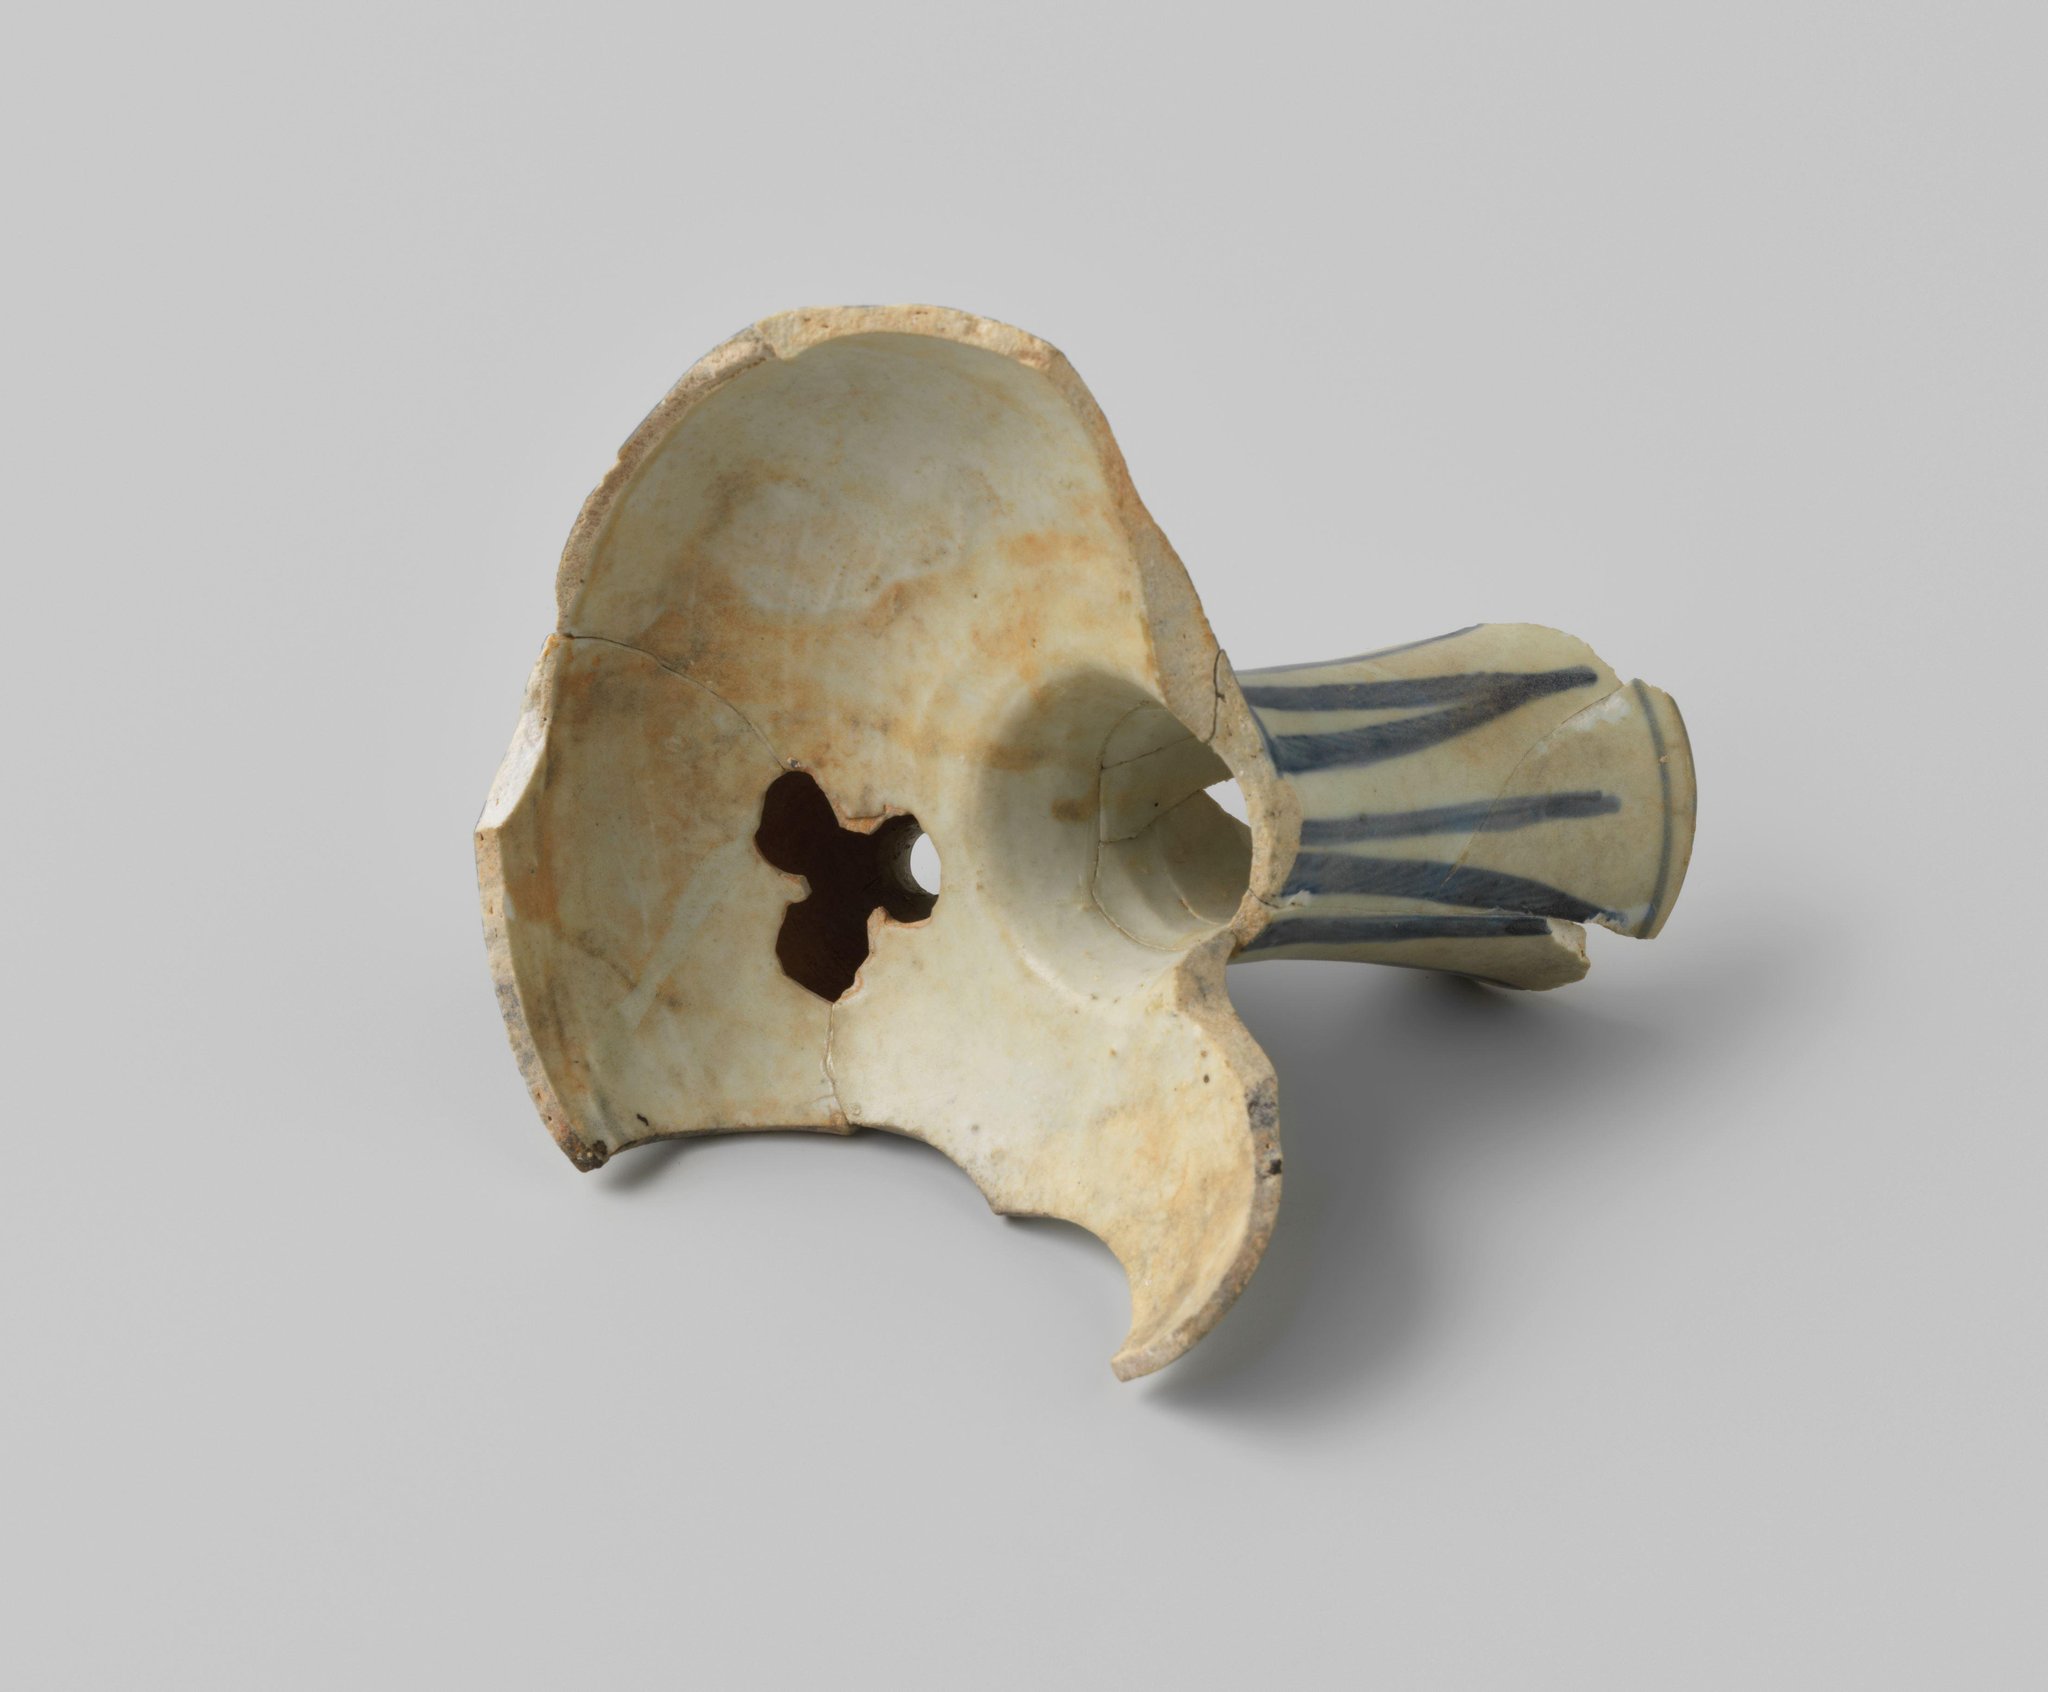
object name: kendi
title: Fragment kendi uit V.O.C.-schip de 'Witte leeuw'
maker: Anonymous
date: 1613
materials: bone china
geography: jingdezhen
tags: verenigde oostindische compagnie, sint-helena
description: Fragment kendi uit V.O.C.-schip de 'Witte leeuw'. Deel van de mond en tuit.